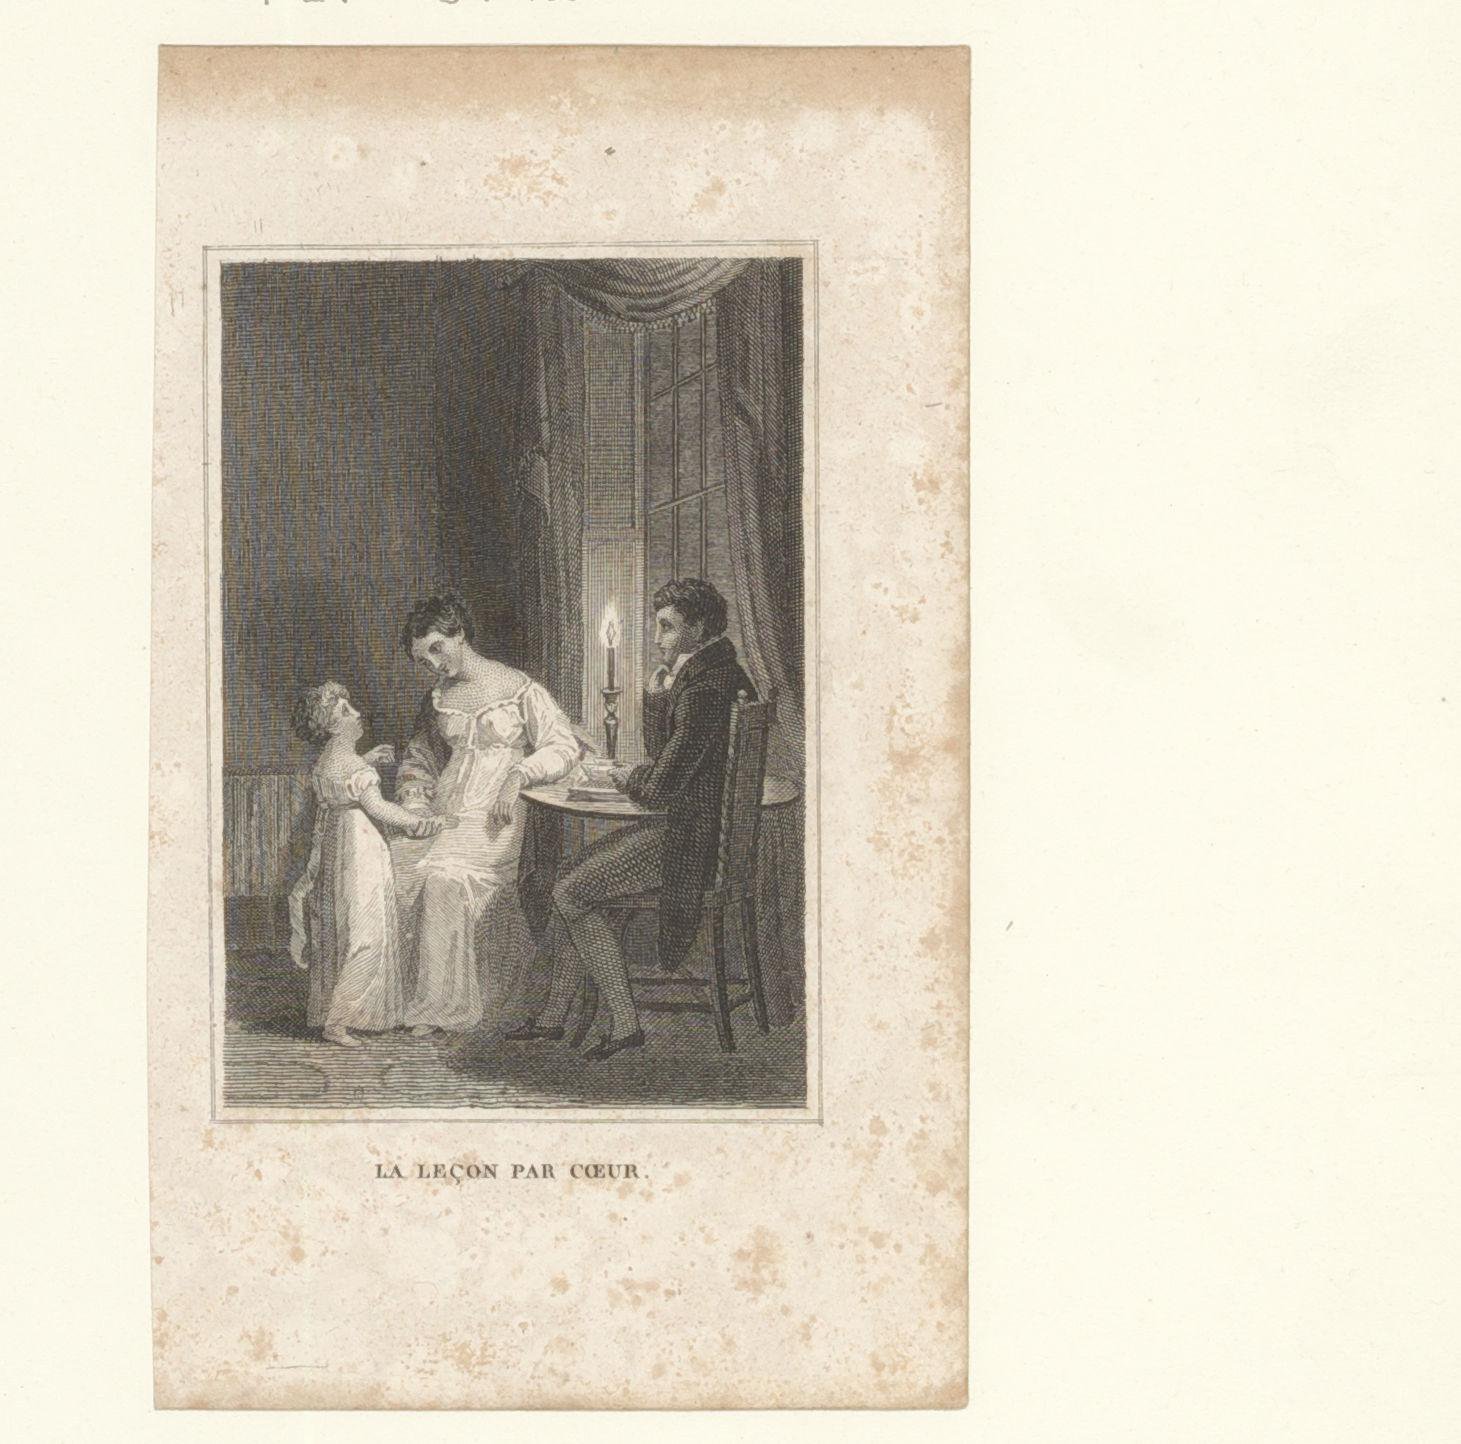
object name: print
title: La leçon par coeur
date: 1800-1899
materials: paper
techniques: etching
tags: reading, writing and letters, family relationships (first, second, third and fourth degree), generations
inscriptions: stamp, collector's mark: Lugt 1641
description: Onderwerpsrubrieken binnen de Atlas Zeden en Gewoonten: Zeden en Gewoonten in Engeren Zin, Des menschen beging, midden en einde, Kinderleven – Kinderspel en Kinderprenten.